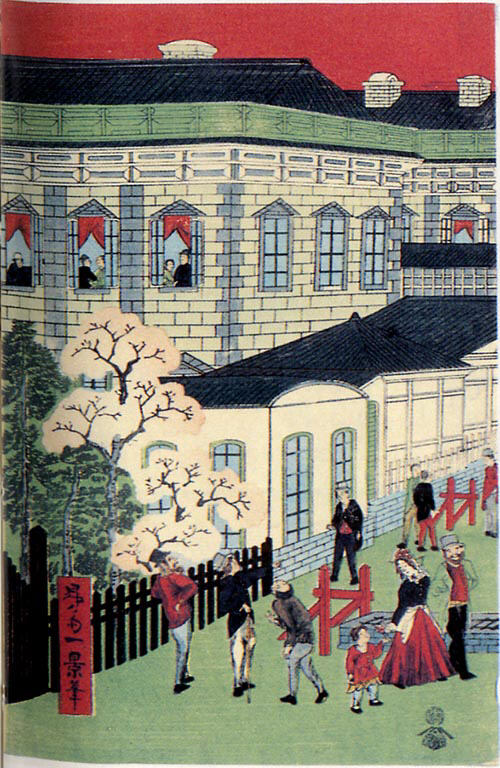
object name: print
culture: japanese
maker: shōsai ikkei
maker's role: artist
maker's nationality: japanese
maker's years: 1870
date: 1870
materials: ink, paper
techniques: woodblock print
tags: buildings,men,women